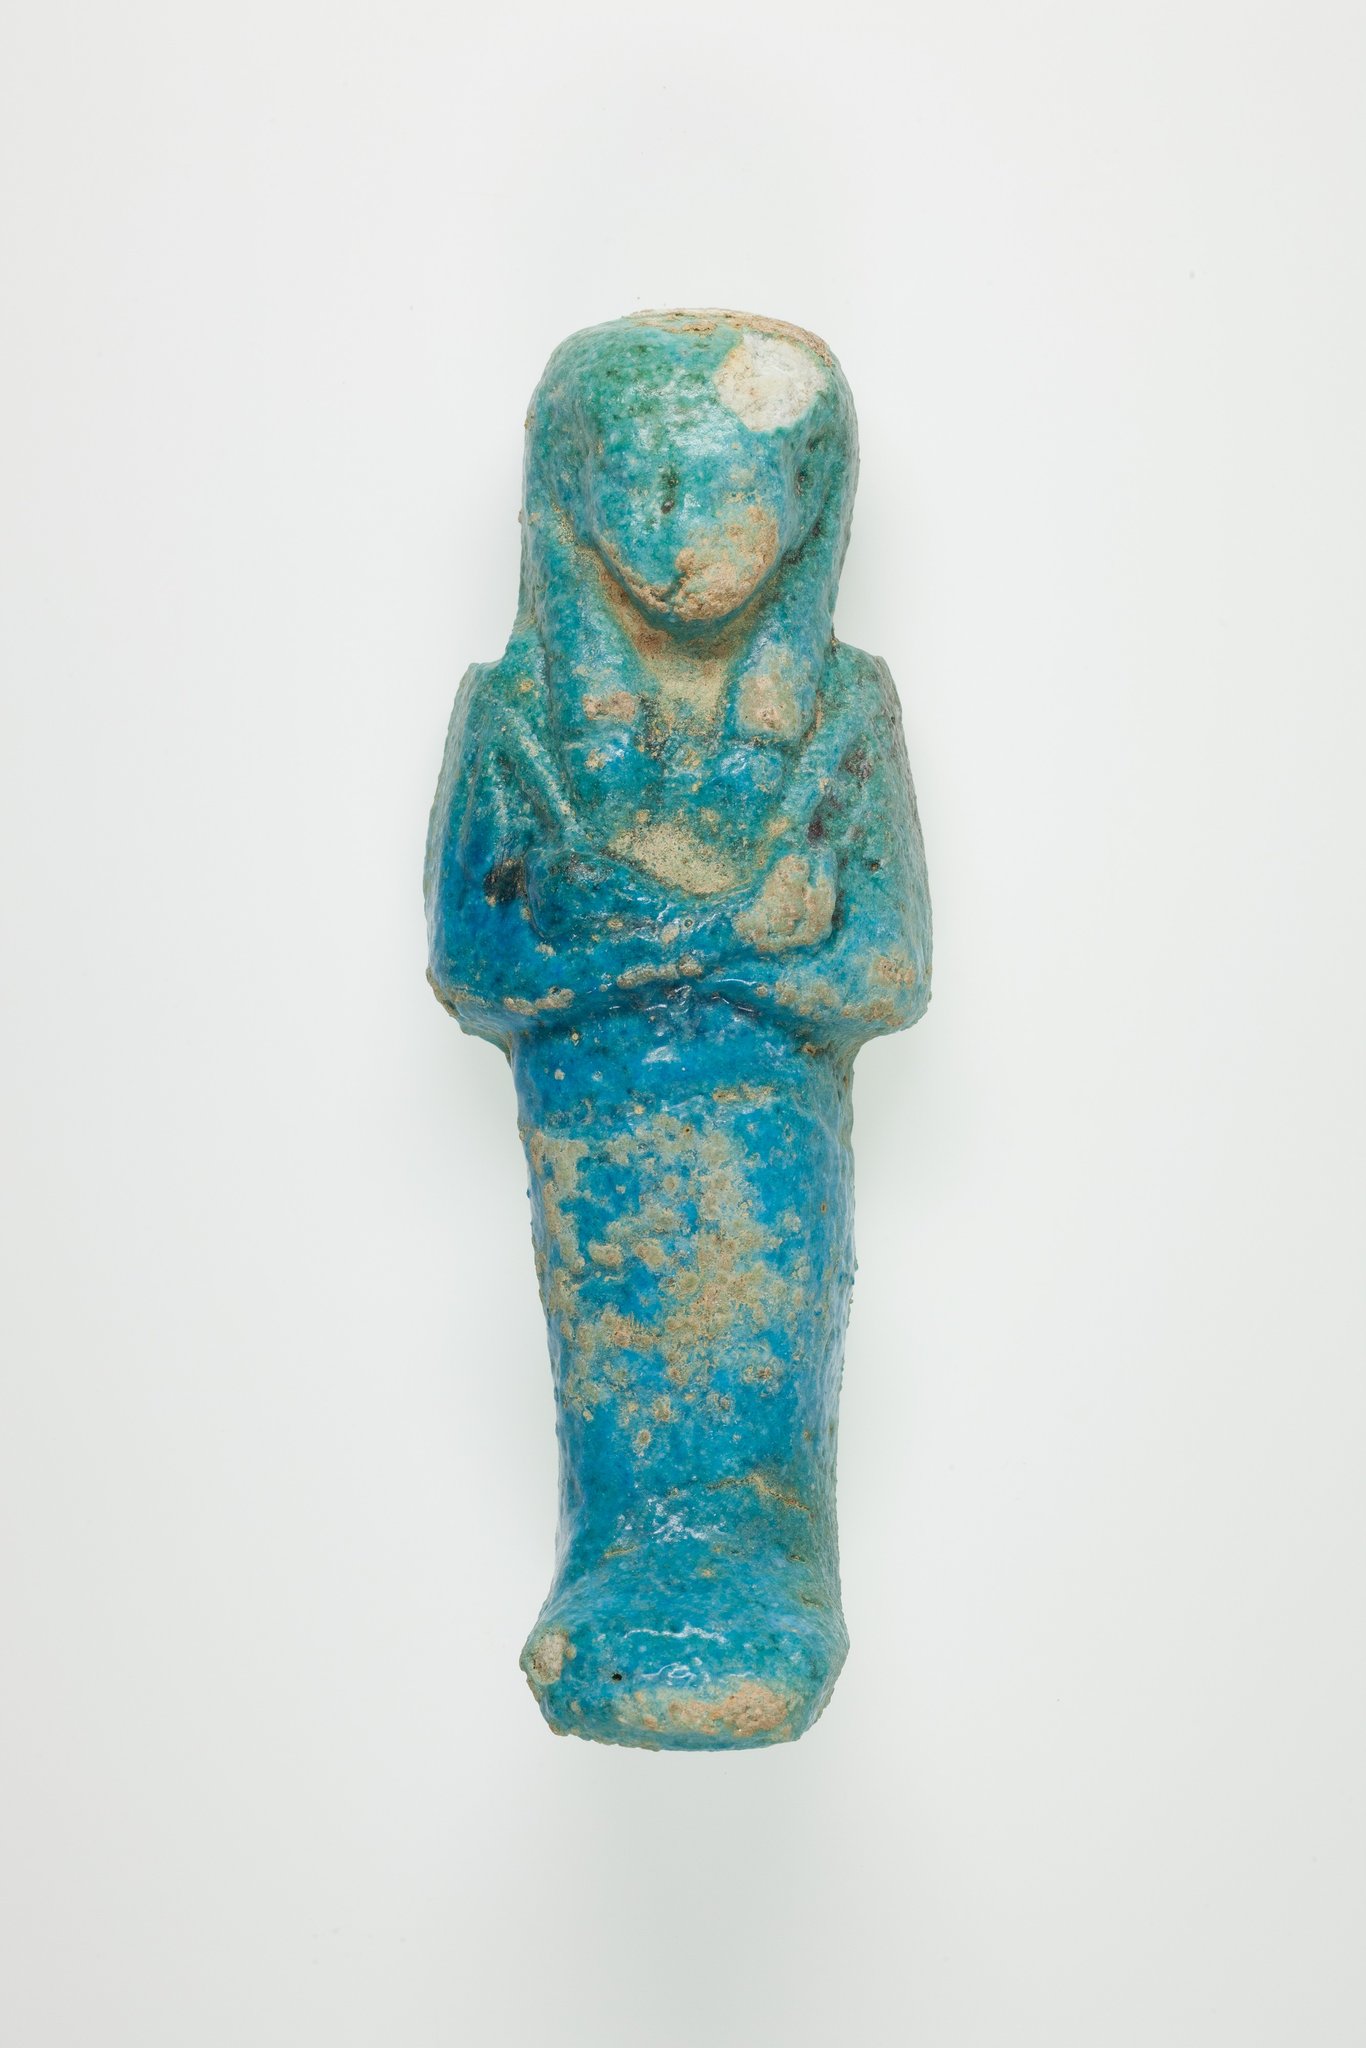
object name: shabti, henettawy c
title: Worker Shabti of Henettawy (C), Daughter of Isetemkheb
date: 990-970 BCE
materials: faience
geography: egypt